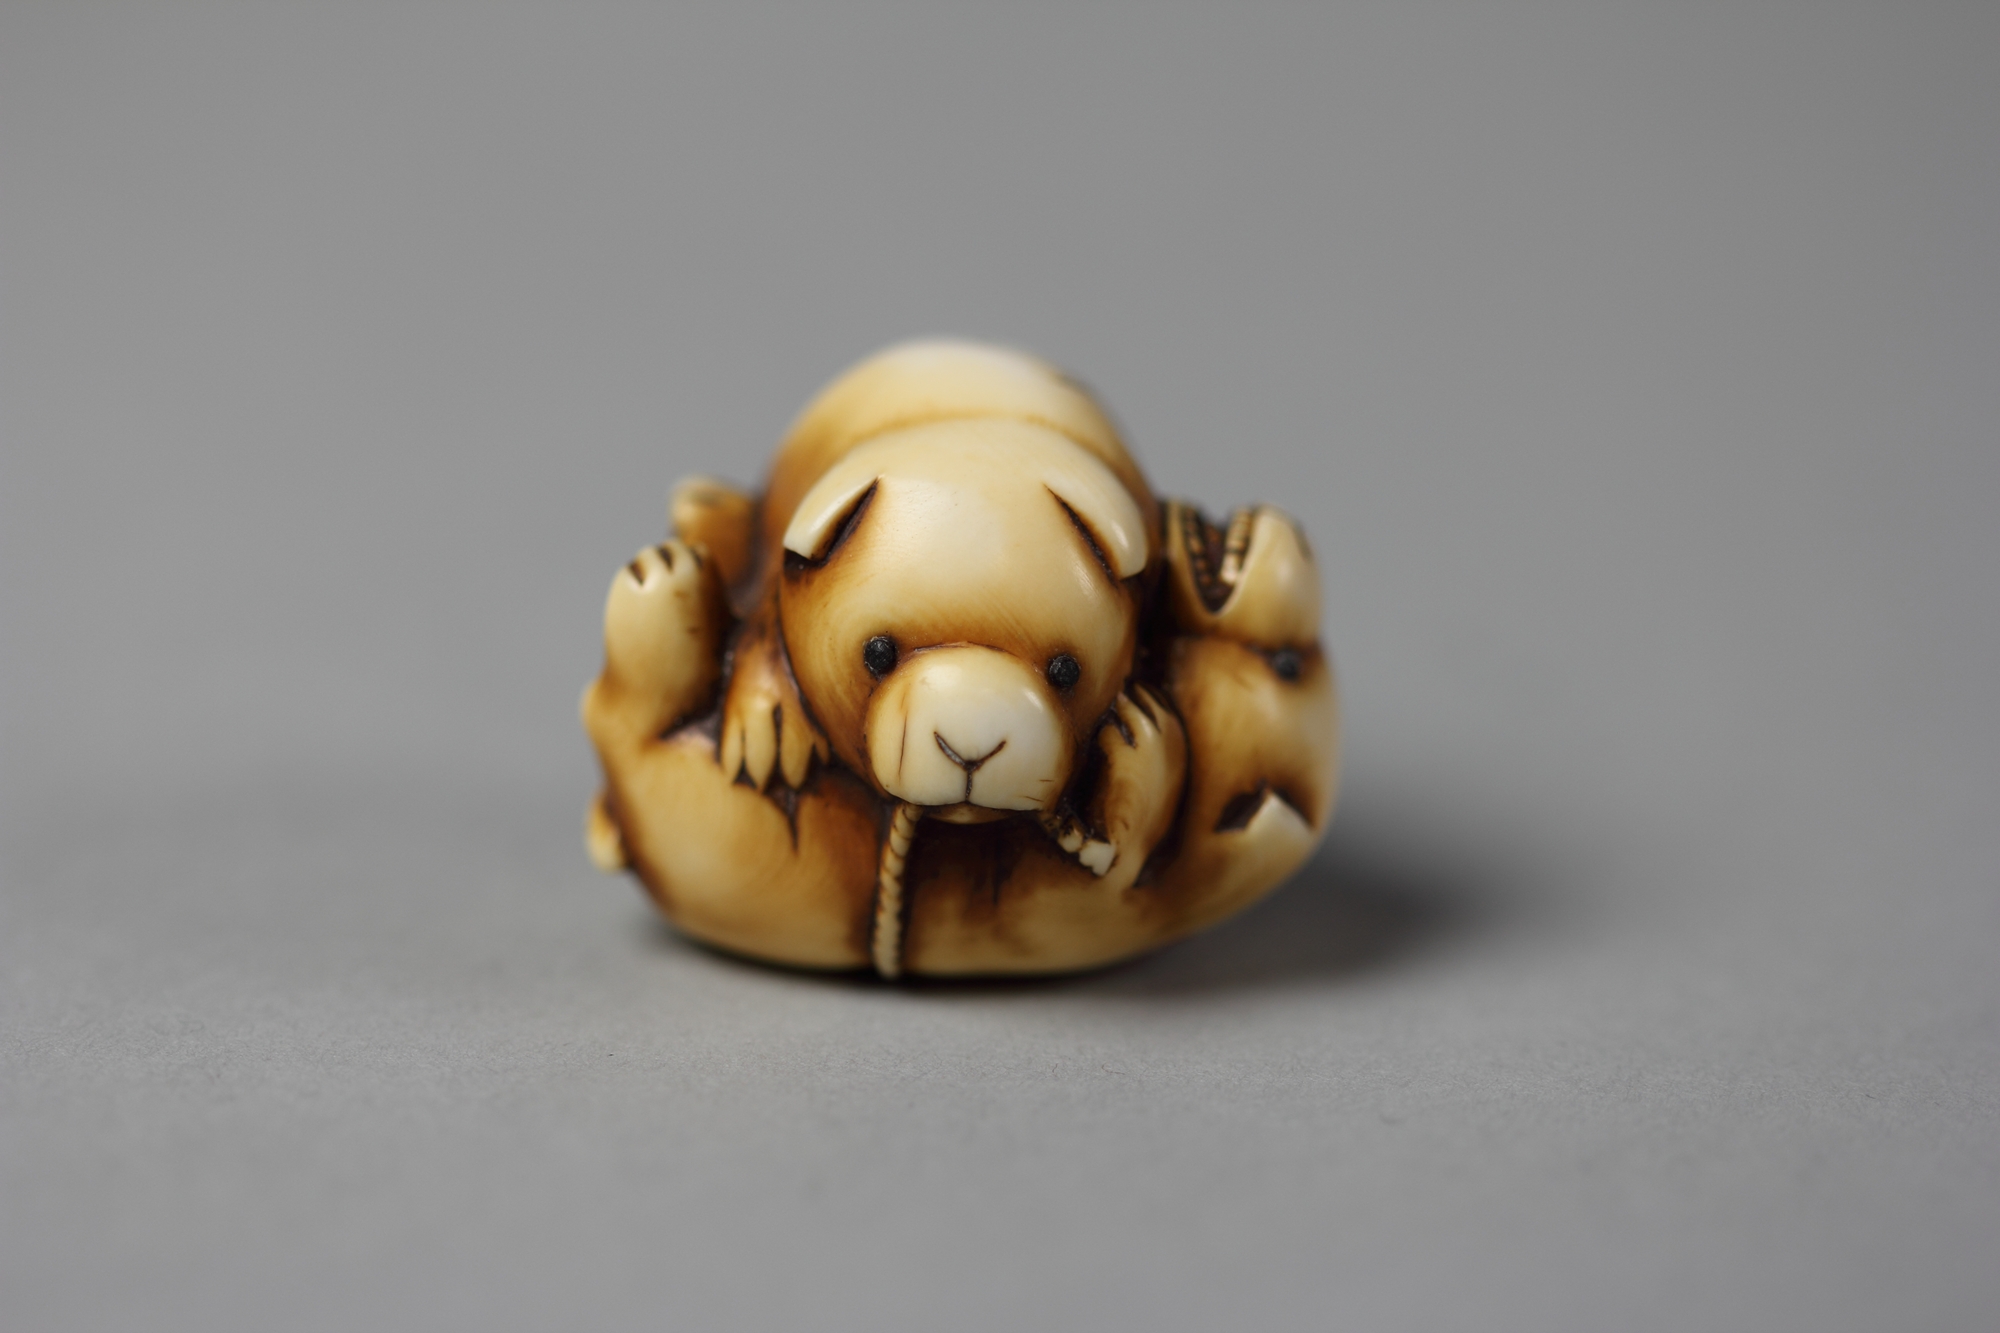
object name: netsuke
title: Netsuke of Puppies at Play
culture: japanese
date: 1867-1900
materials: ivory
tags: dogs